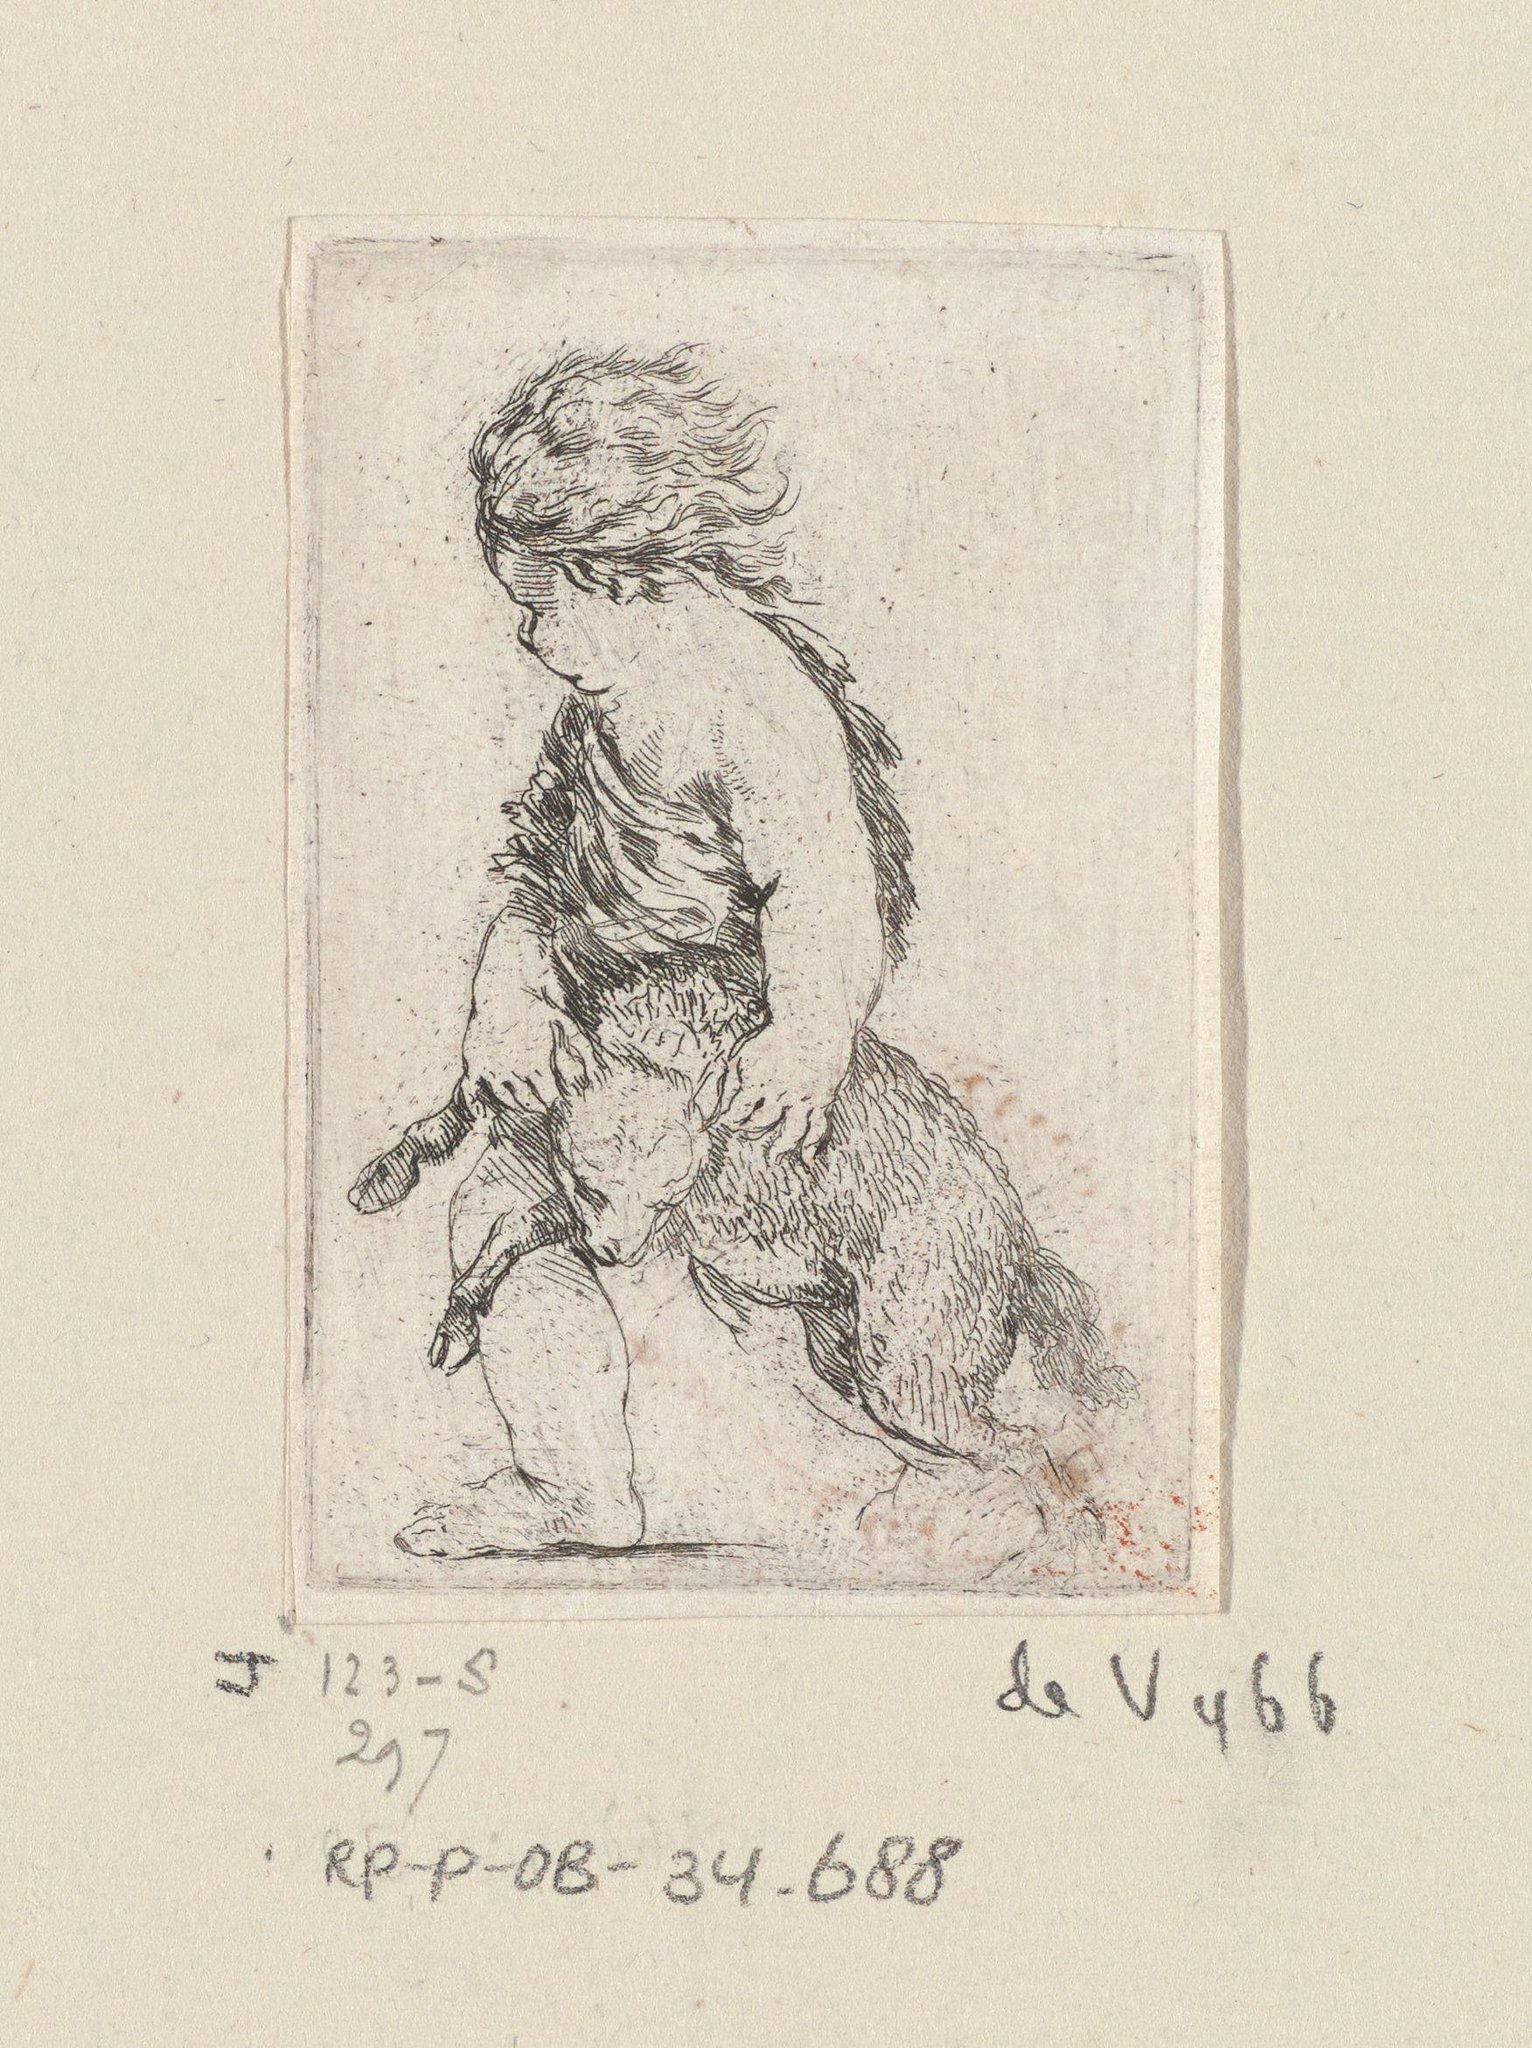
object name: print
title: Kind met lam (mogelijk Johannes de Doper)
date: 1620-1664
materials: paper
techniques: etching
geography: paris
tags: child, lamb, series of scenes from the life of john the baptist, child playing with animals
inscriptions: collector's mark: Lugt 240